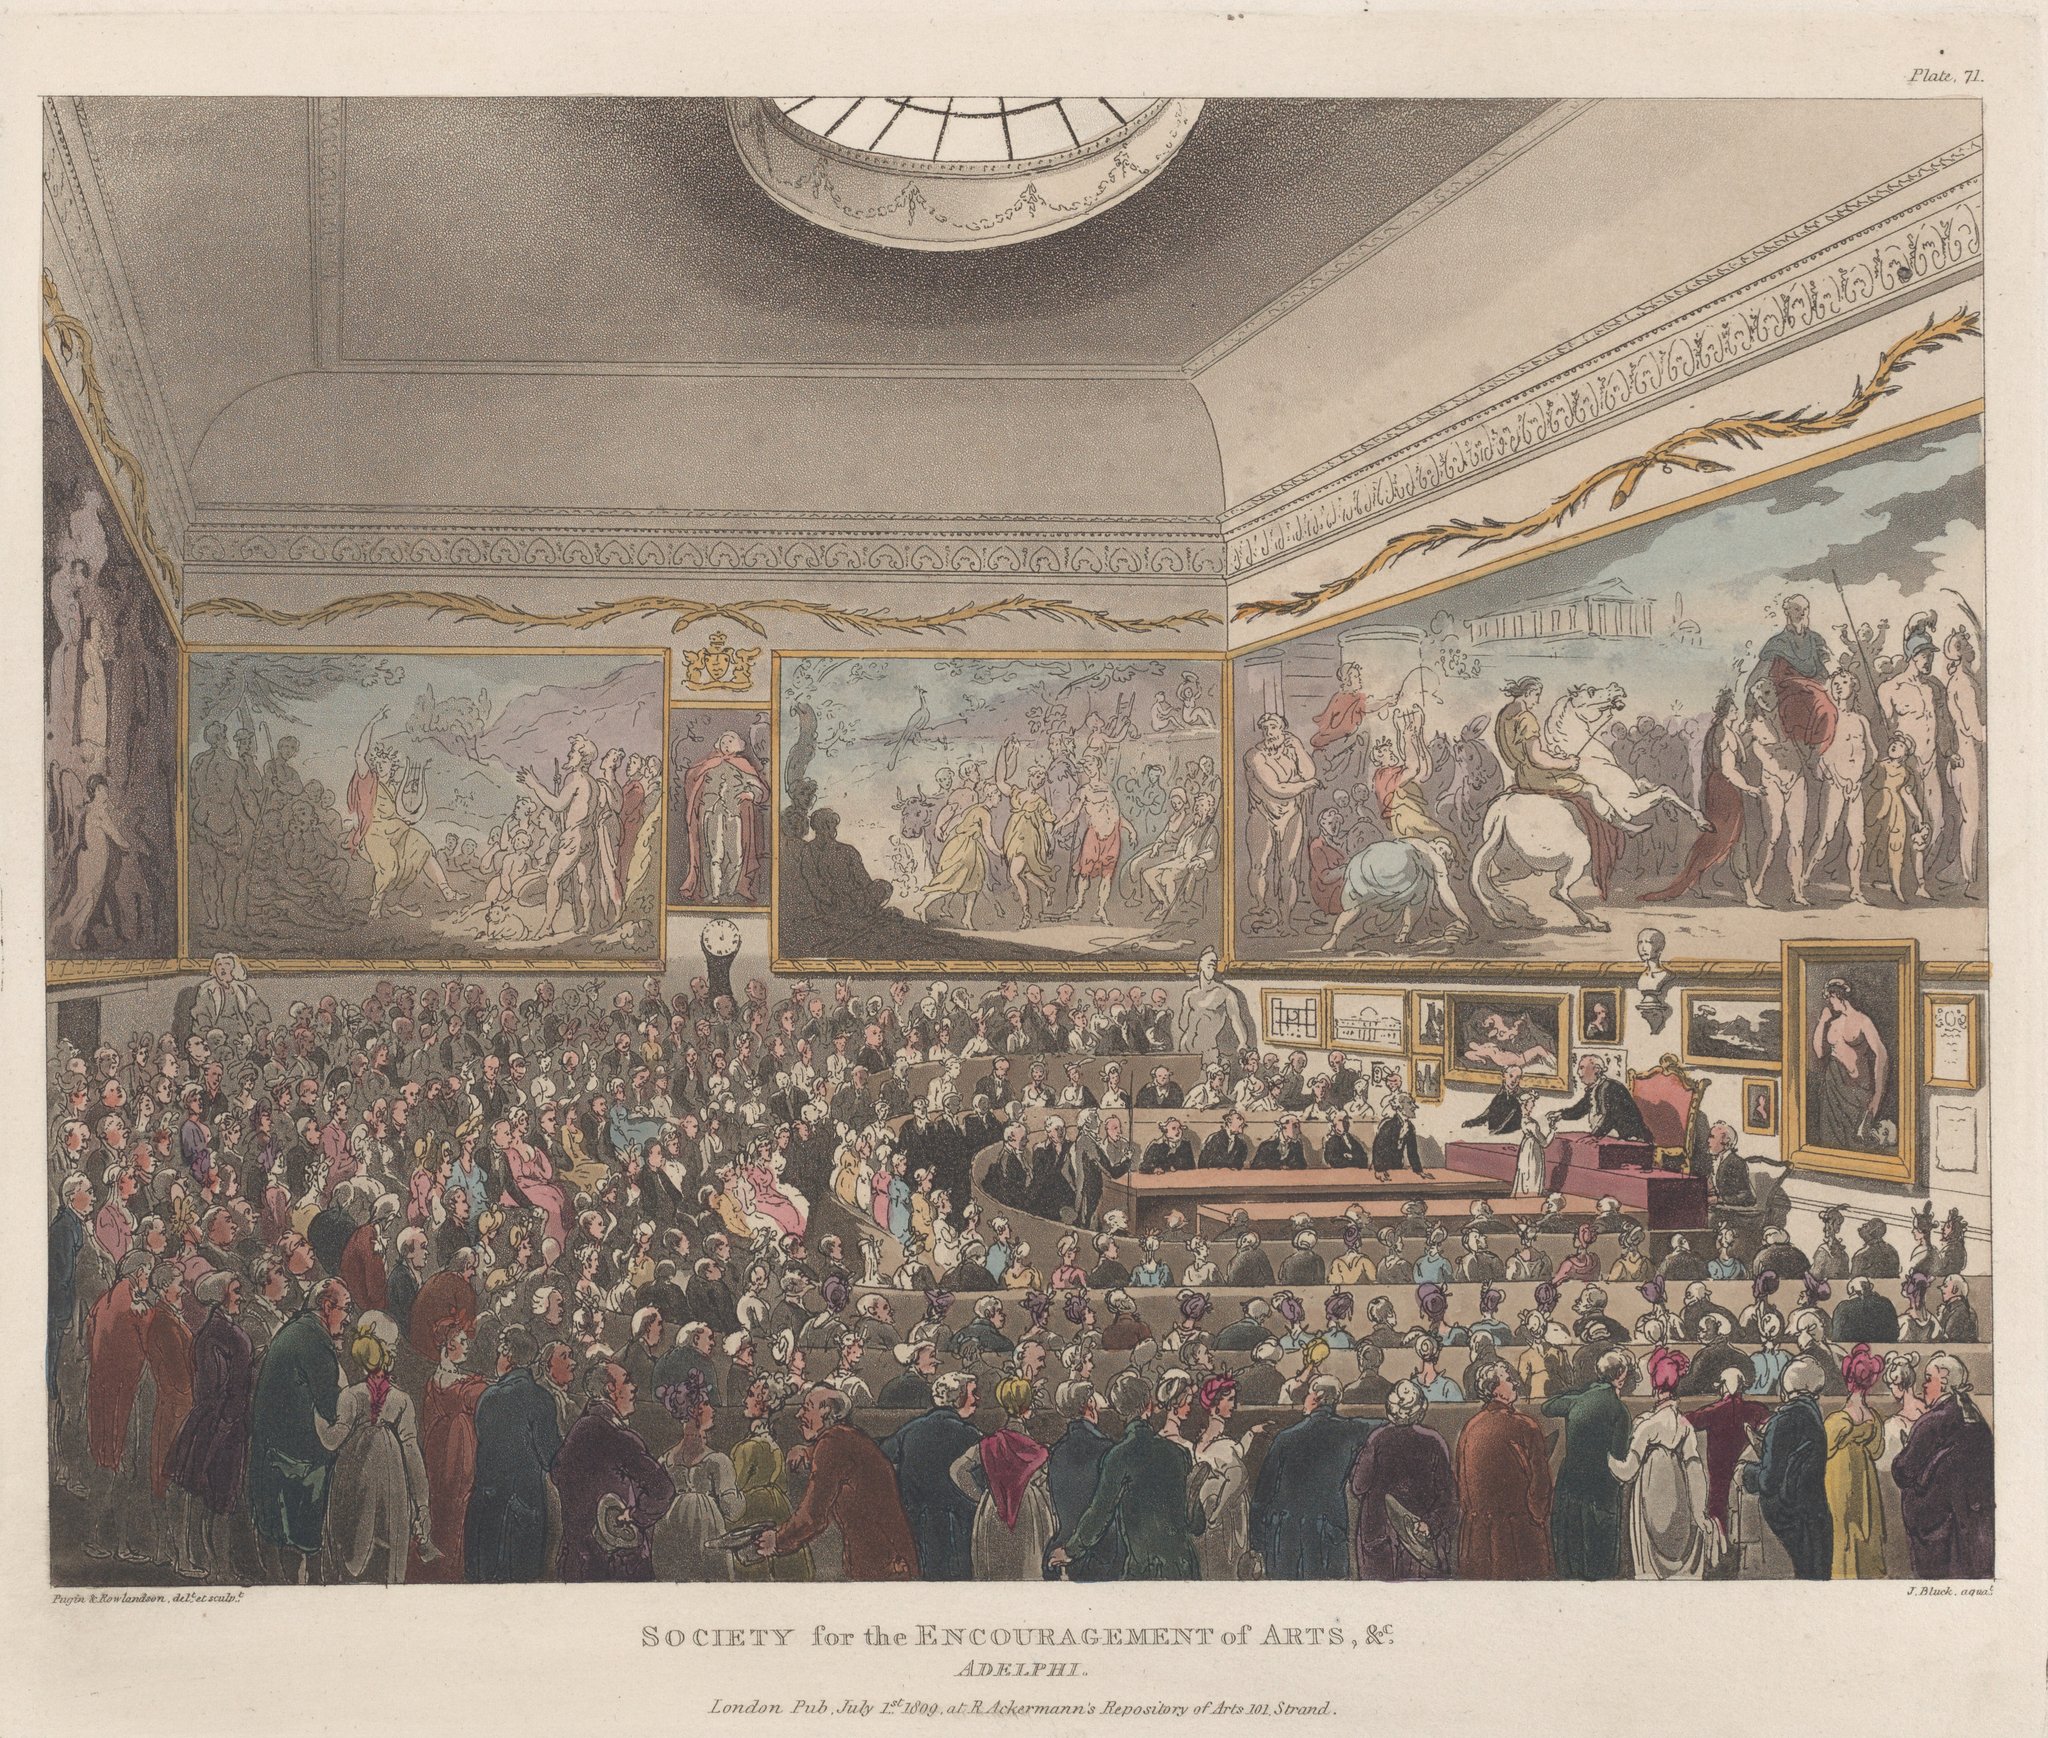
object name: print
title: Society for the Encouragement of Arts etc., Adelphi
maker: thomas rowlandson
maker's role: artist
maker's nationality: british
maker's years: 1757-1827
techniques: aquatint, etching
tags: interiors,spectators